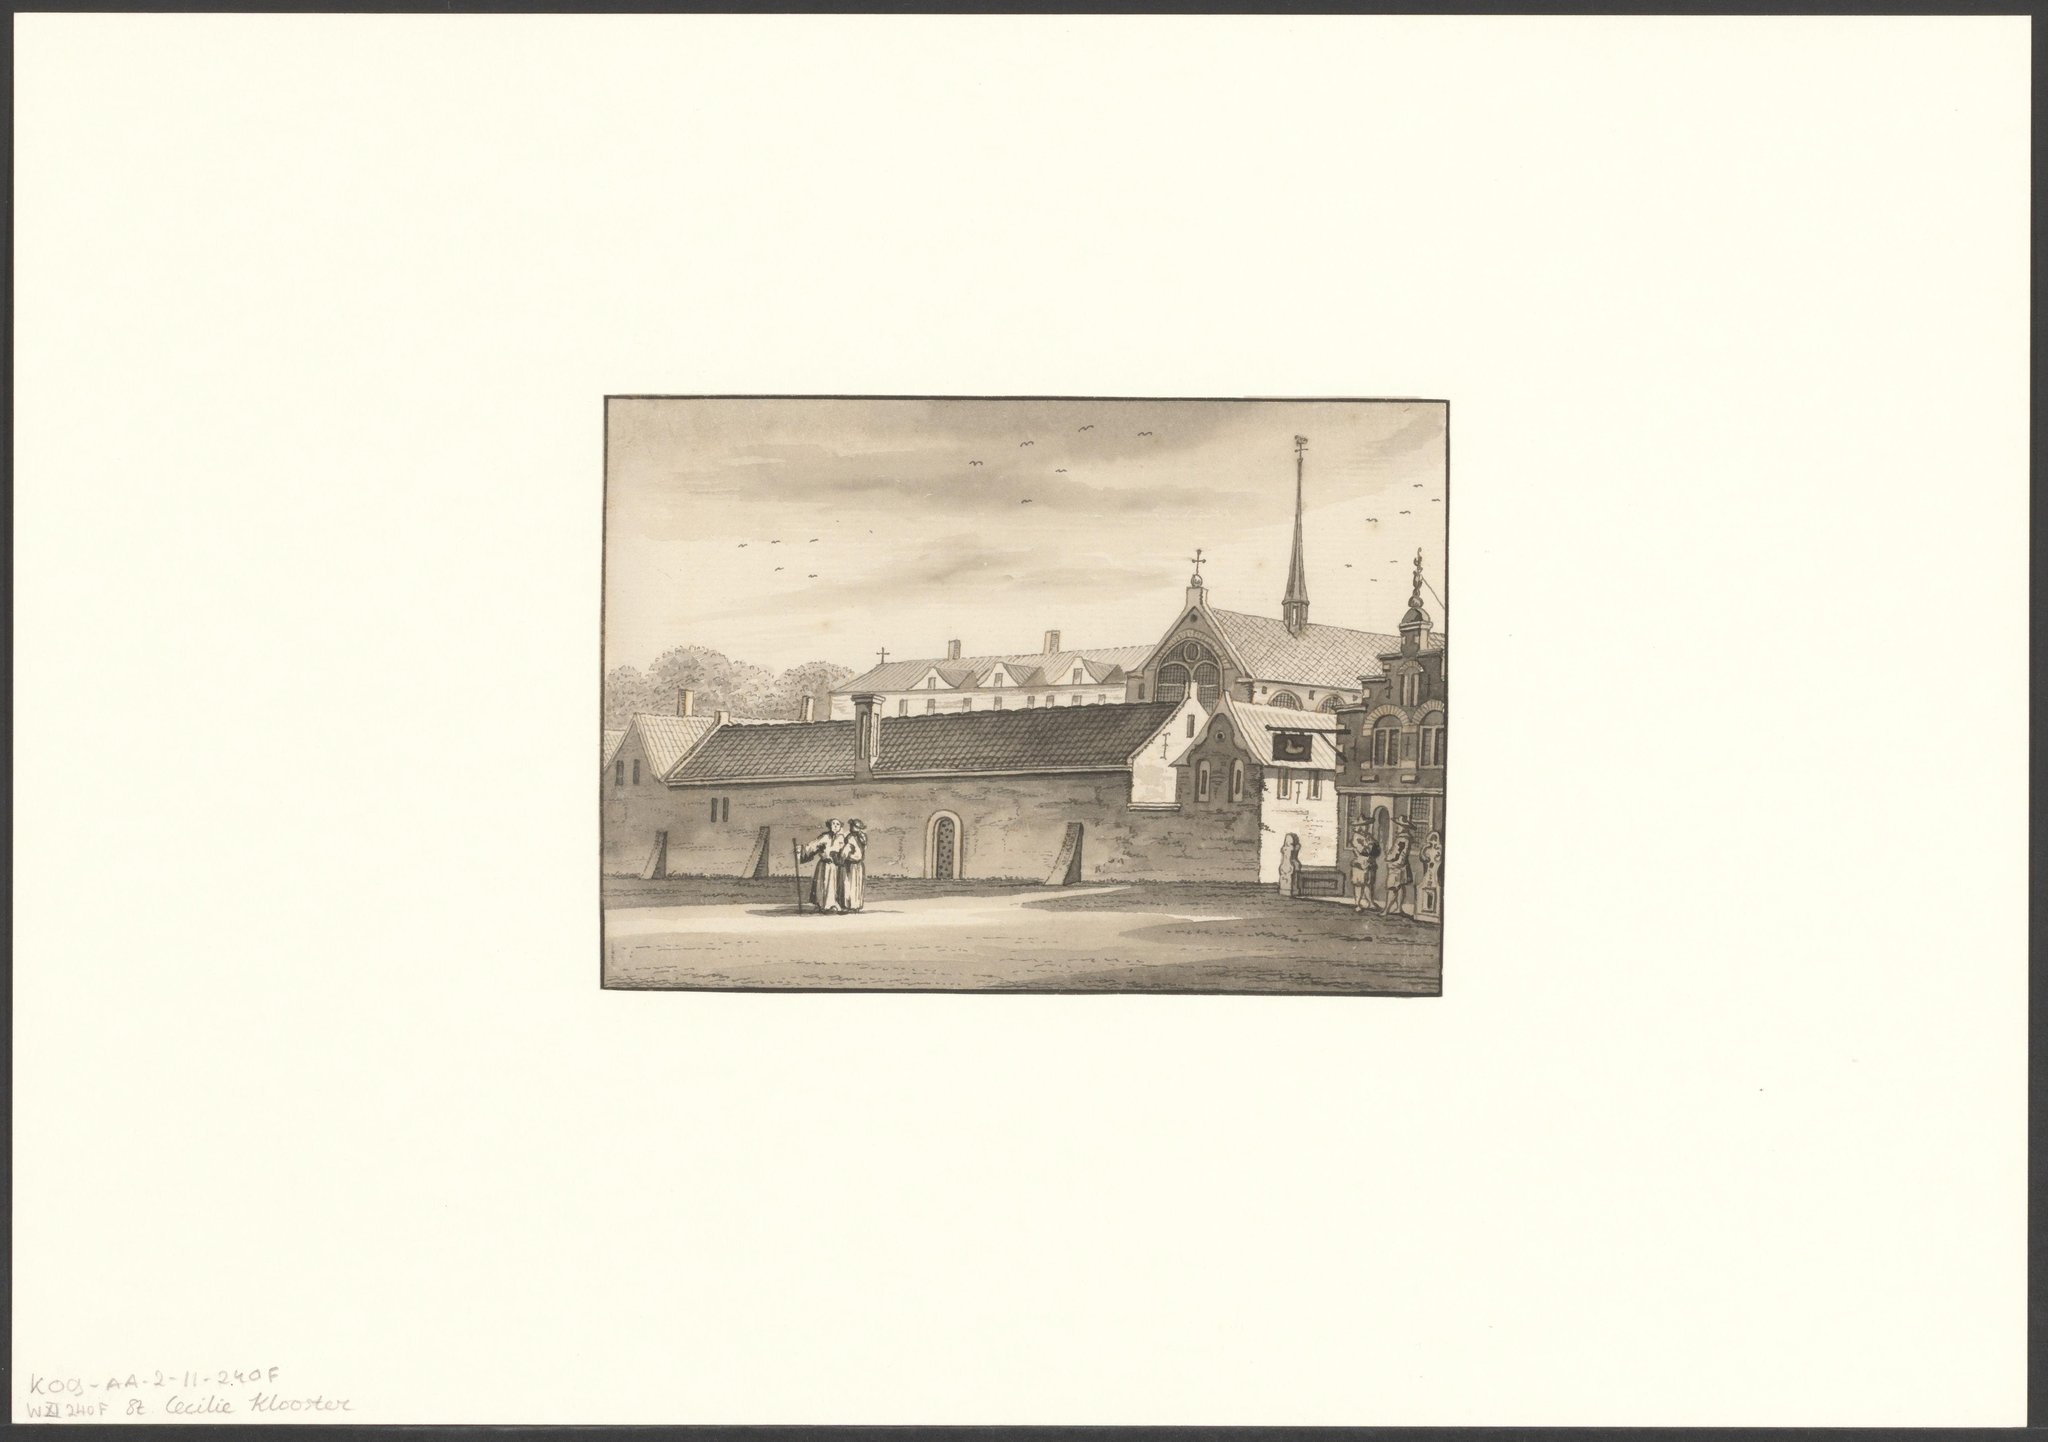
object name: drawing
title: Gezicht op de Oudezijds Achterburgwal gezien naar het Sint Ceciliaklooster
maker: Anonymous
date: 1700-1799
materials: ink, paper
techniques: brush, pen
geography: amsterdam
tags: city-view, and landscape with man-made constructions, abbey, monastery, convent ~ roman catholic church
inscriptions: inscription: ‘Cecilien klooster’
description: Tekening binnen de Atlas Van Eck ingedeeld op wijknummer 11.